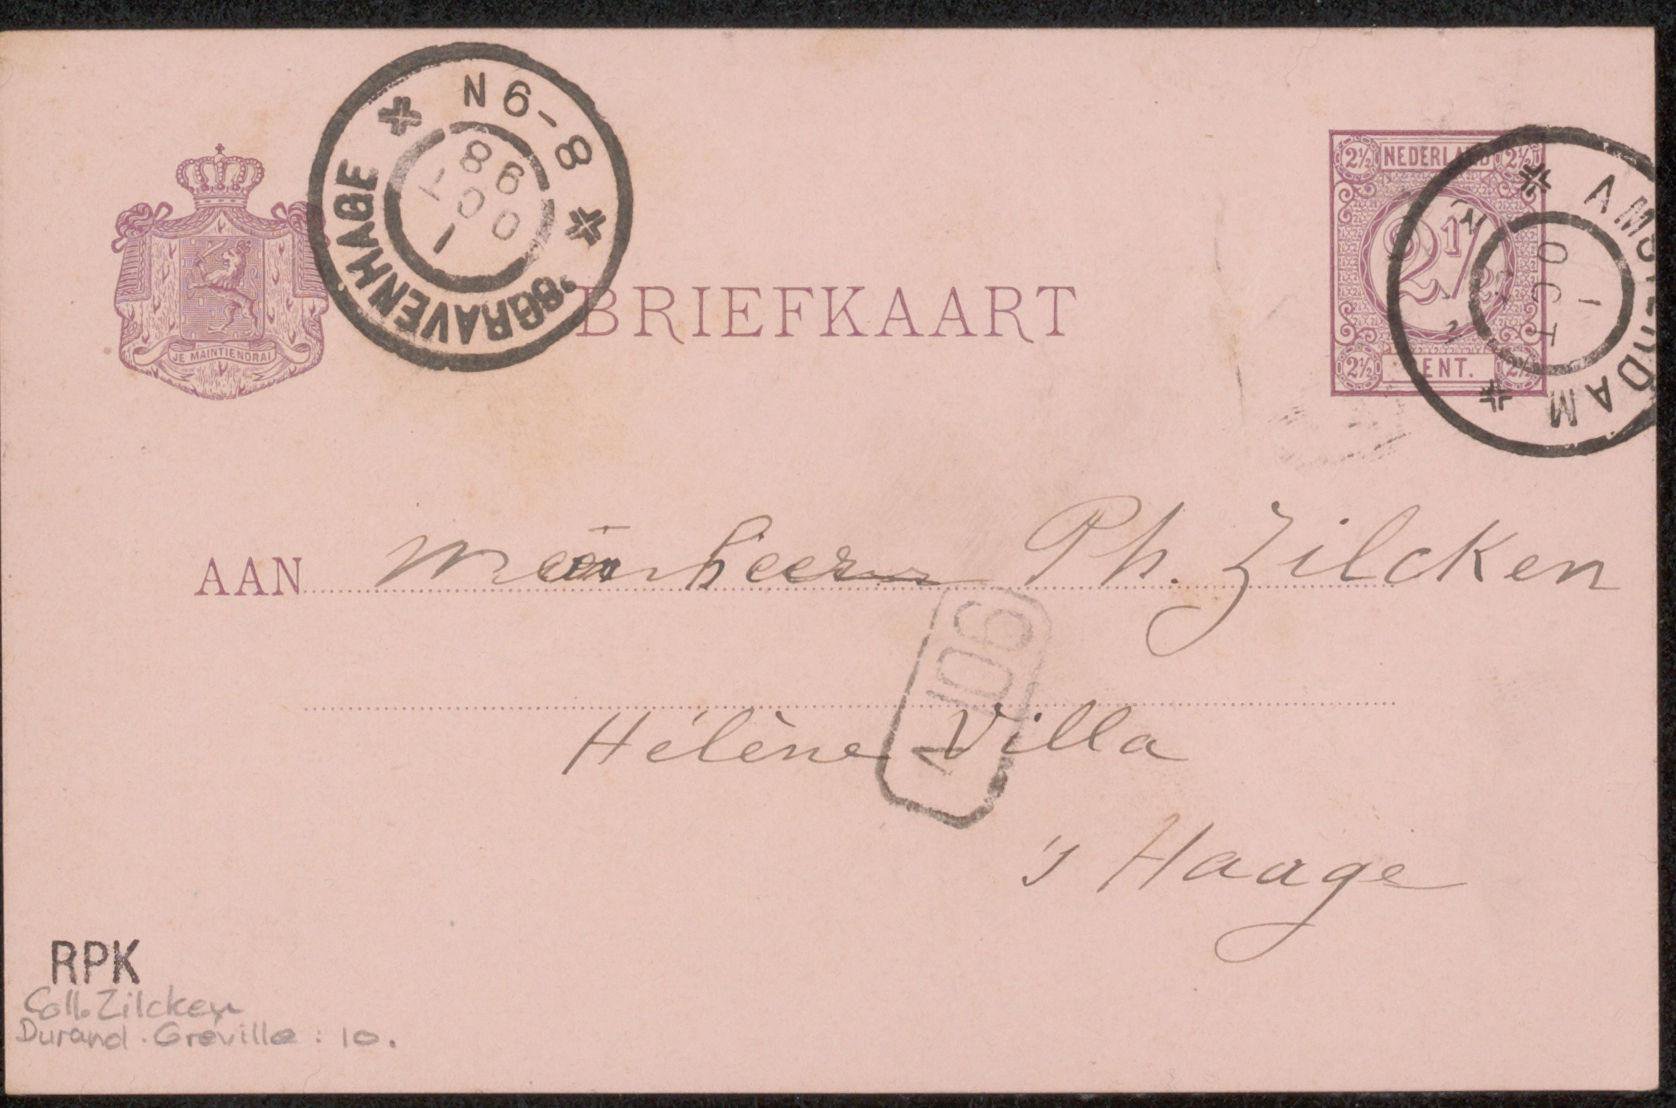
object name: postcard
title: Briefkaart aan Philip Zilcken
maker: émile durand-gréville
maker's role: schrijver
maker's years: 1838-1914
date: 1898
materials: cardboard, ink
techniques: pen, writing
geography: amsterdam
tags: the hague, nijmegen, print maker, adriaan pit, amsterdam, abraham bredius, painter, philip zilcken, travelling; tourism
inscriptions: collector's mark: ‘RPK’